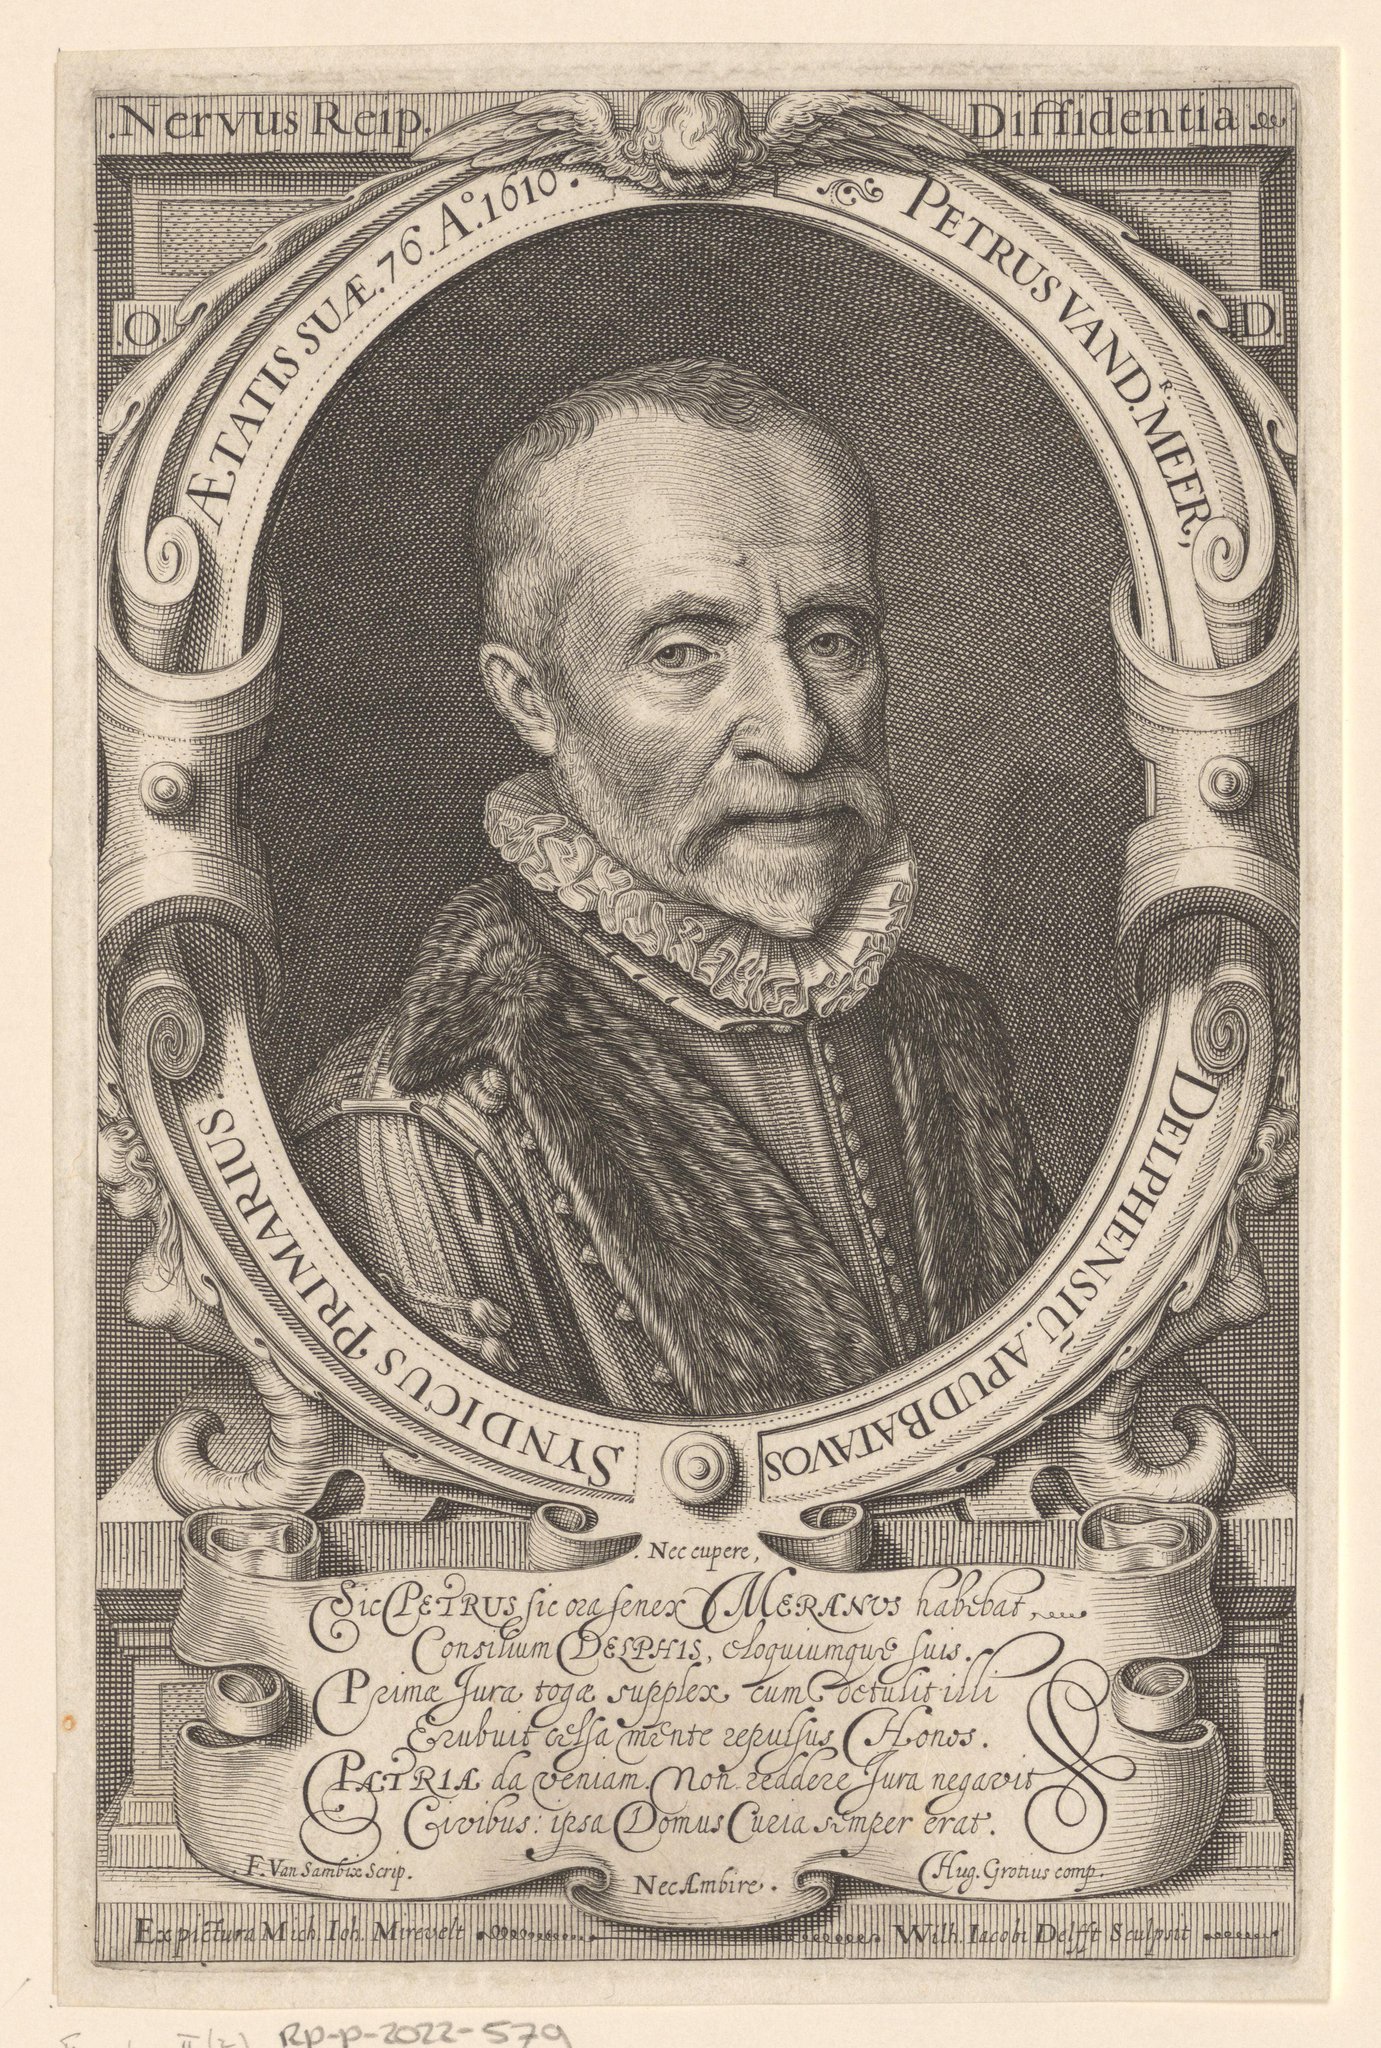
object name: print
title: Portret van Petrus van der Meer op 76-jarige leeftijd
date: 1610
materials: paper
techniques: engraving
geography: delft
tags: historical persons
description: Met zesregelig onderschrift in het Latijn.